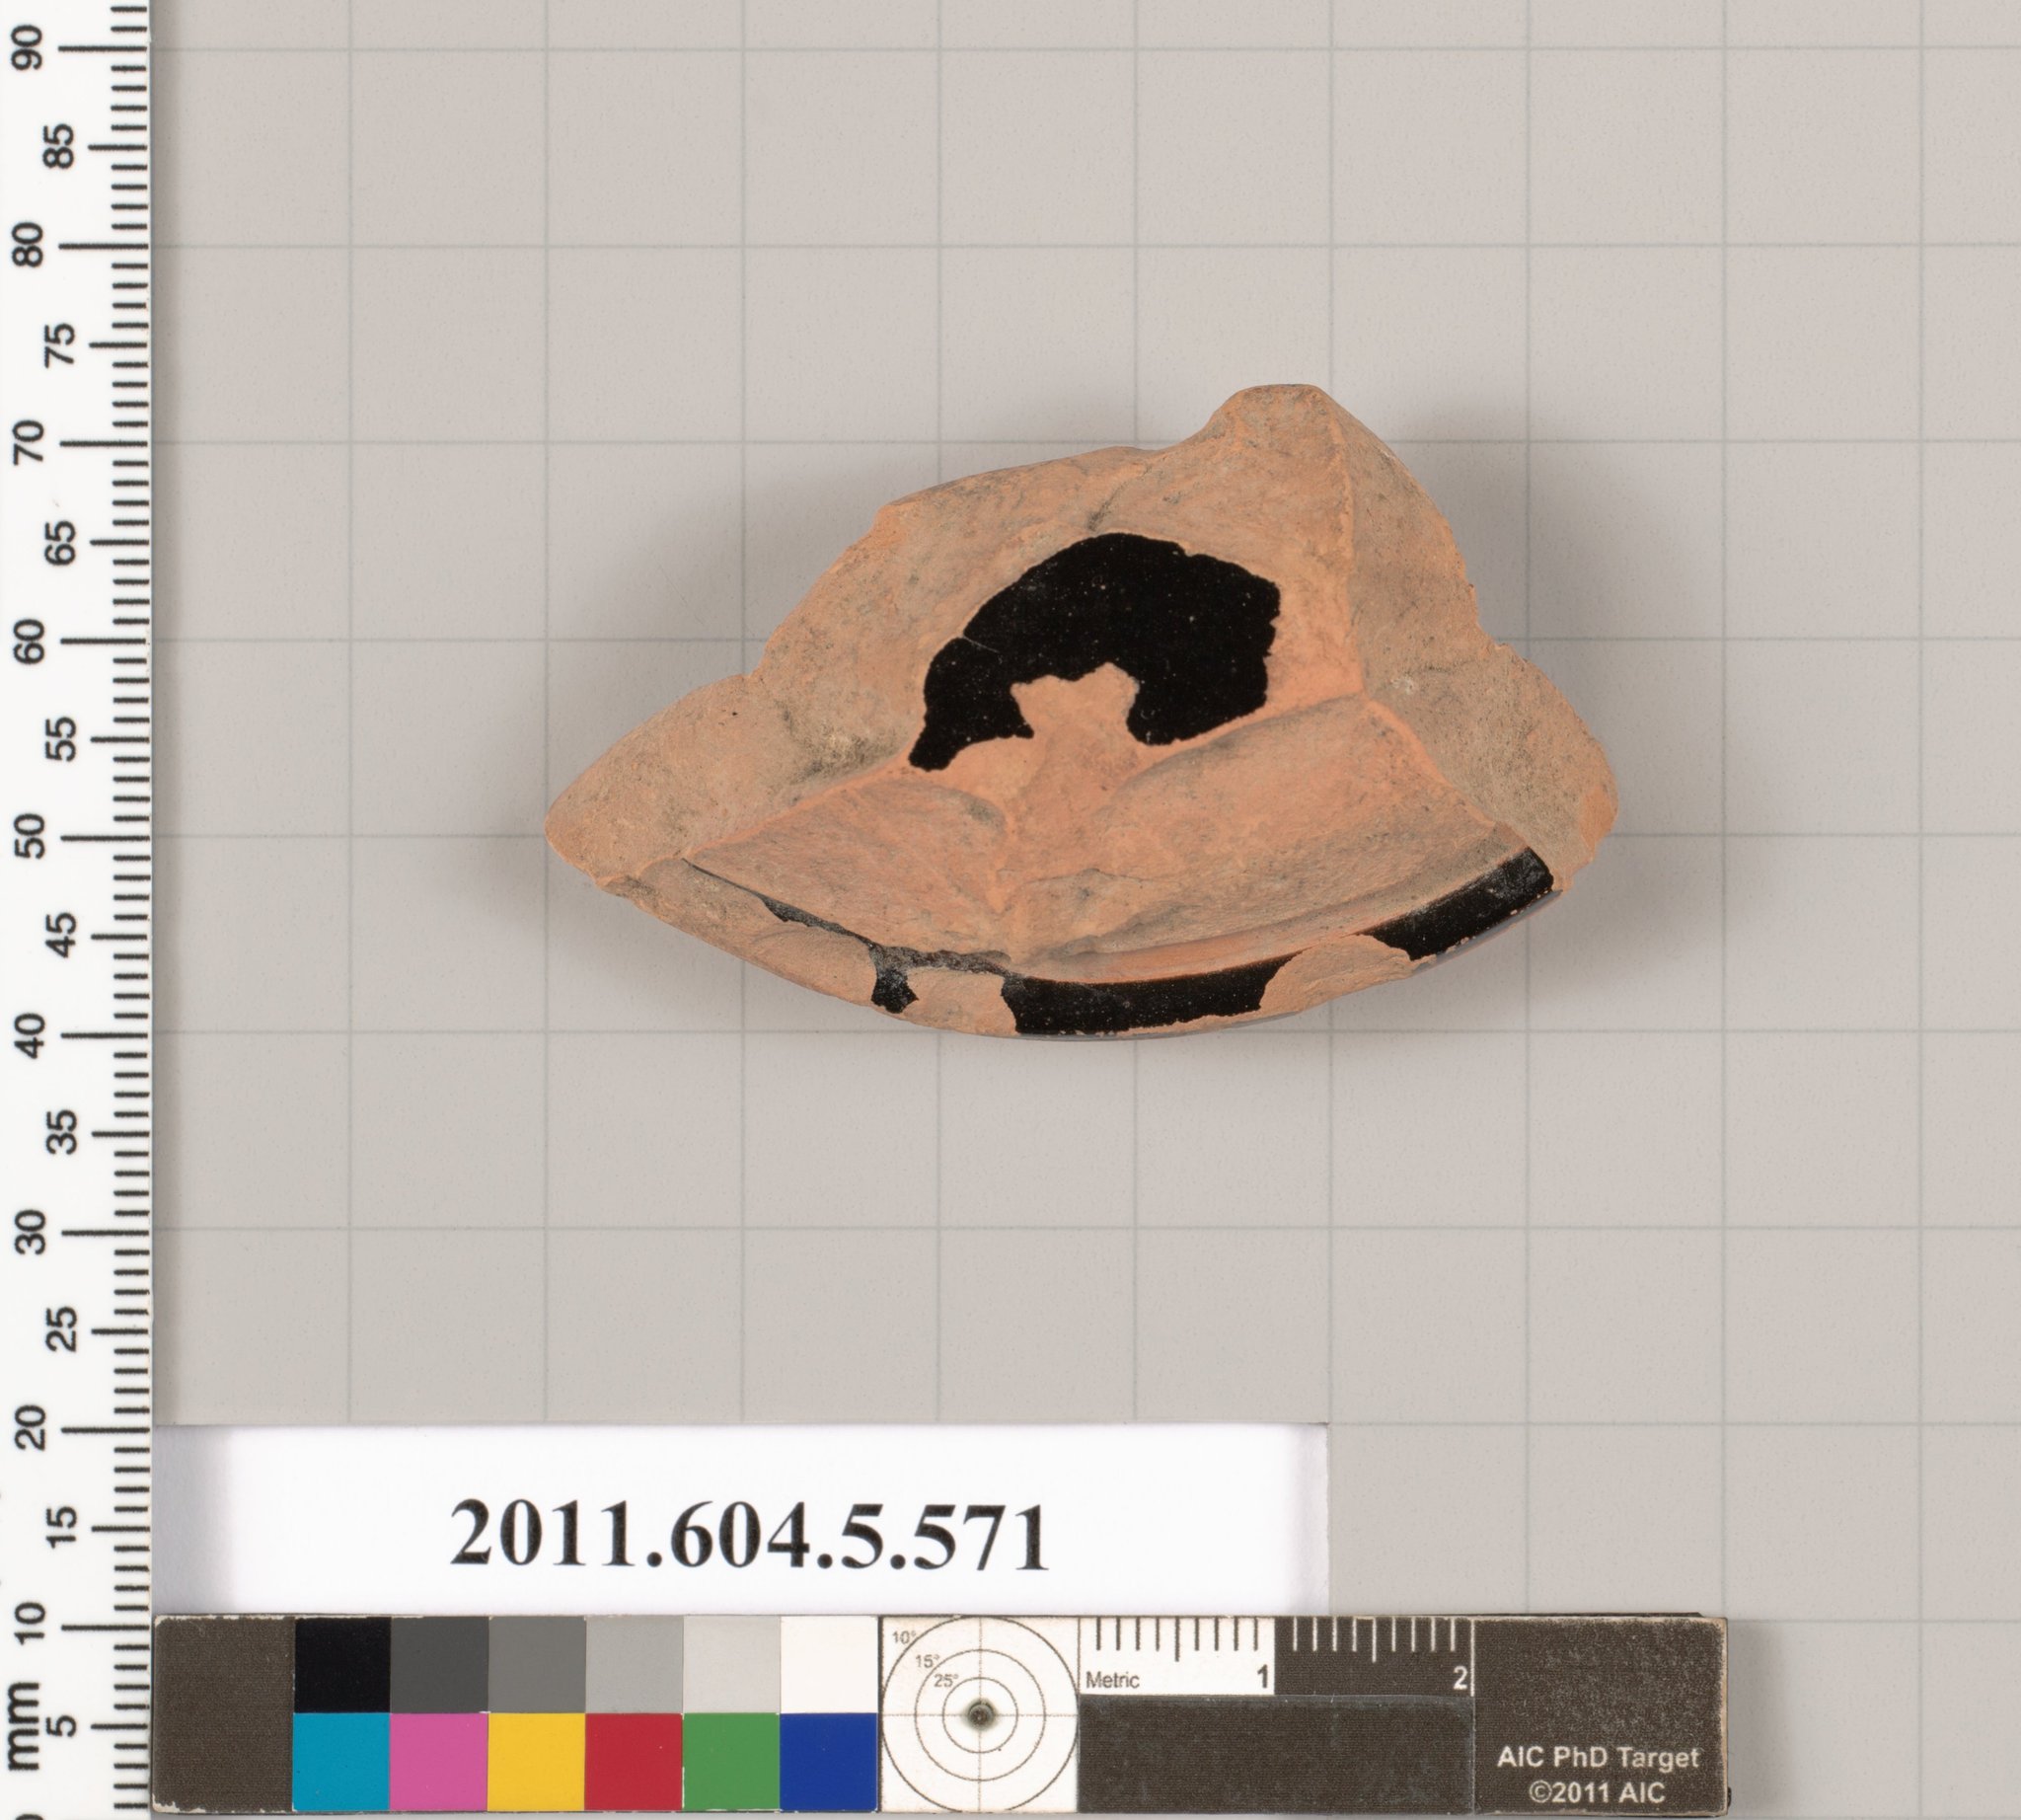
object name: stemless kylix fragment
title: Terracotta fragment of a stemless kylix (drinking cup)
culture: greek, attic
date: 600-401 BCE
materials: terracotta